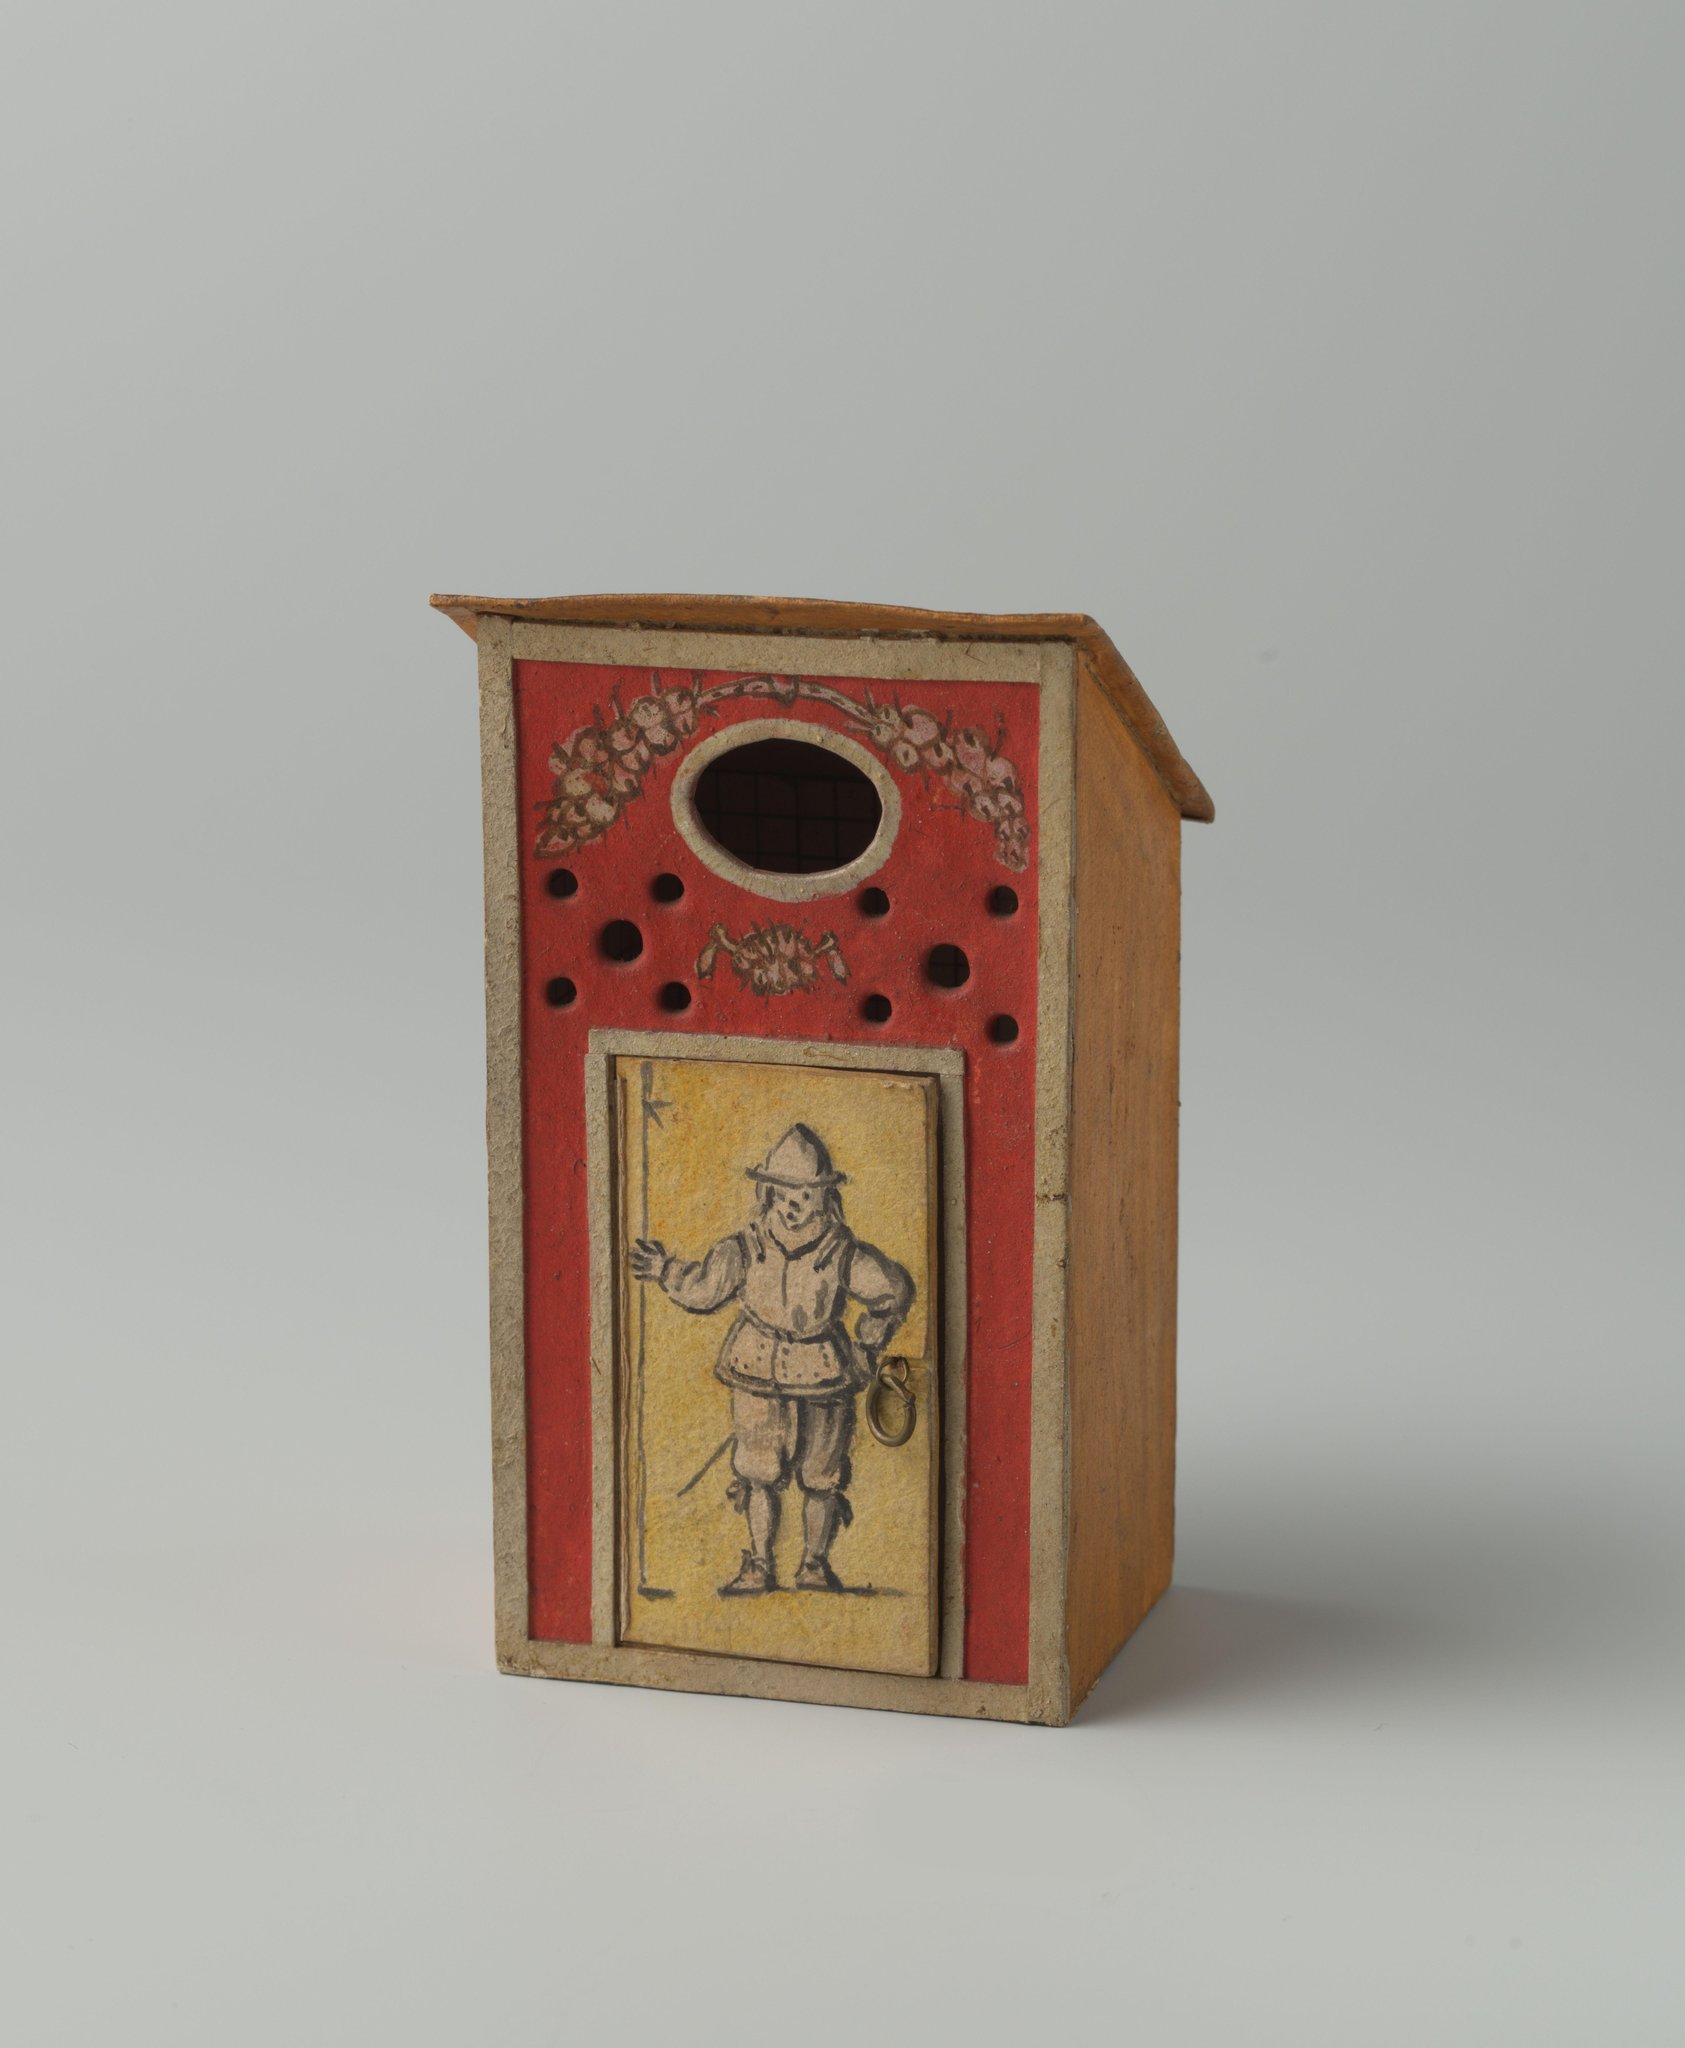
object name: miniature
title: Secreet vervaardigd van bordpapier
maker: Anonymous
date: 1676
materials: gouache, metal, board, varnish, wood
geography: amsterdam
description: Secreet, vervaardigd van bordpapier, met aflopend dak, scharnierende deur met metalen ring als knop en een ovaal luchtgat, waarnaast twee keer vijf gaten. De voorzijde is rood met een gele deur. De deur beschilderd met een vruchtenguirlande en een staande man met buidel (soldaat?). De zijkant en achterkant zijn okergeel. Binnenin is een secreetplank aangebracht met gat en en papieren bak. Op de wanden zijn lijnen getrokken alsof er tegels zijn aangebracht.